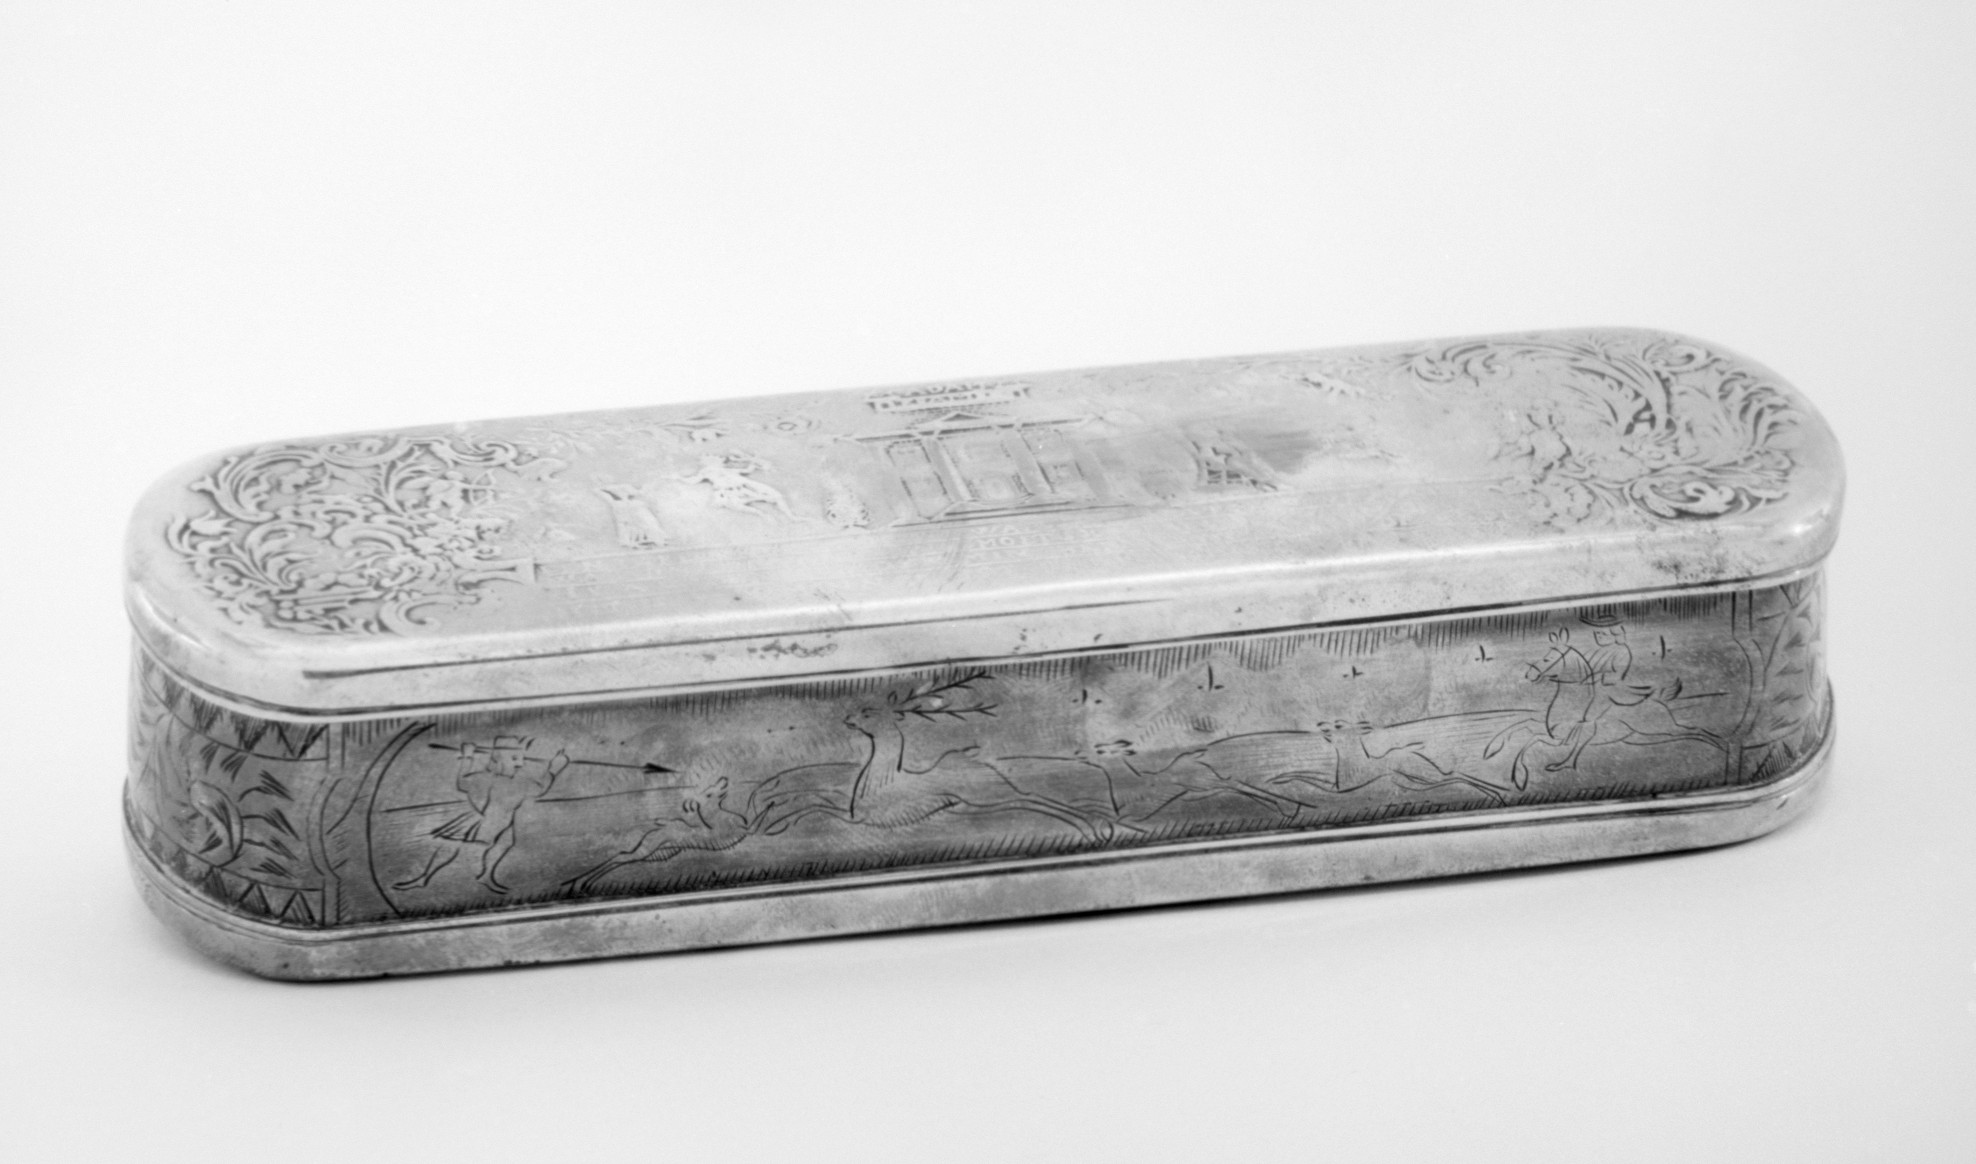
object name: tobacco box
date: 1701-1800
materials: brass, copper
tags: hunting,deer,horses